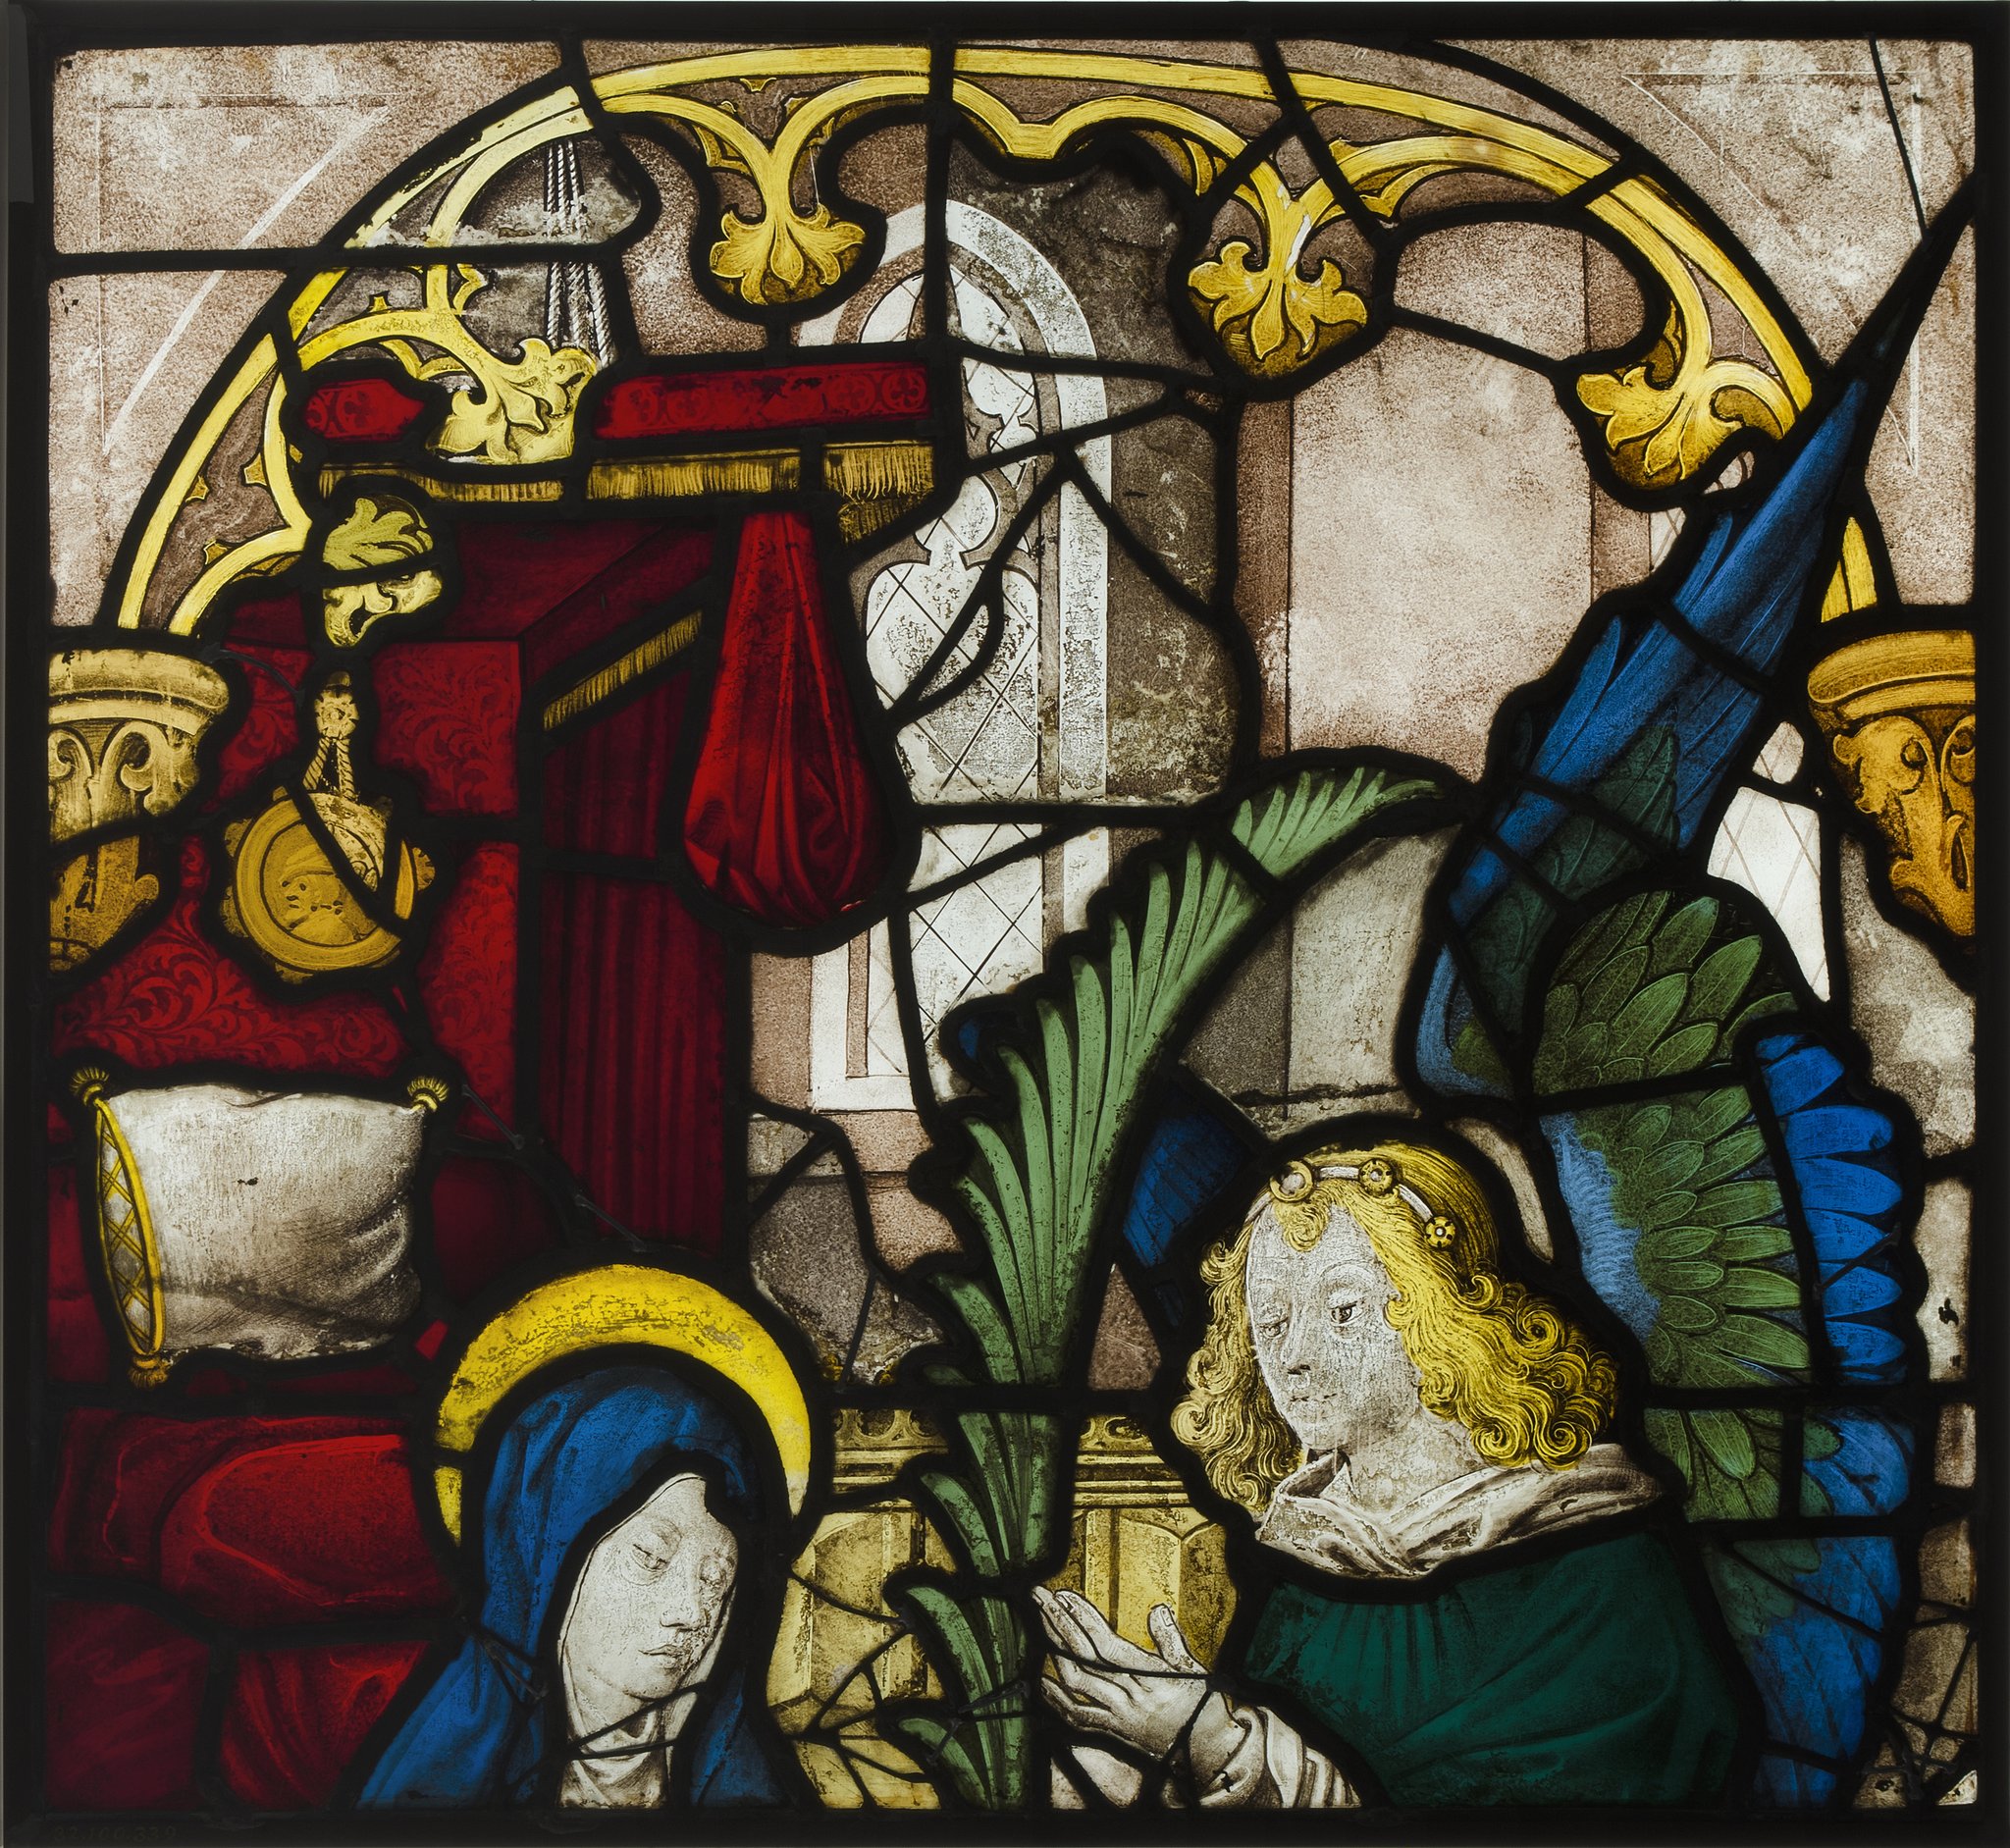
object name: panel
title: Annunciation of the Death of of the Virgin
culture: french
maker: master of the life of saint john the baptist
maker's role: artist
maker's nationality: french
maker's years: 1450-1550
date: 1500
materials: glass, metal, paint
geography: france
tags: angels,virgin mary